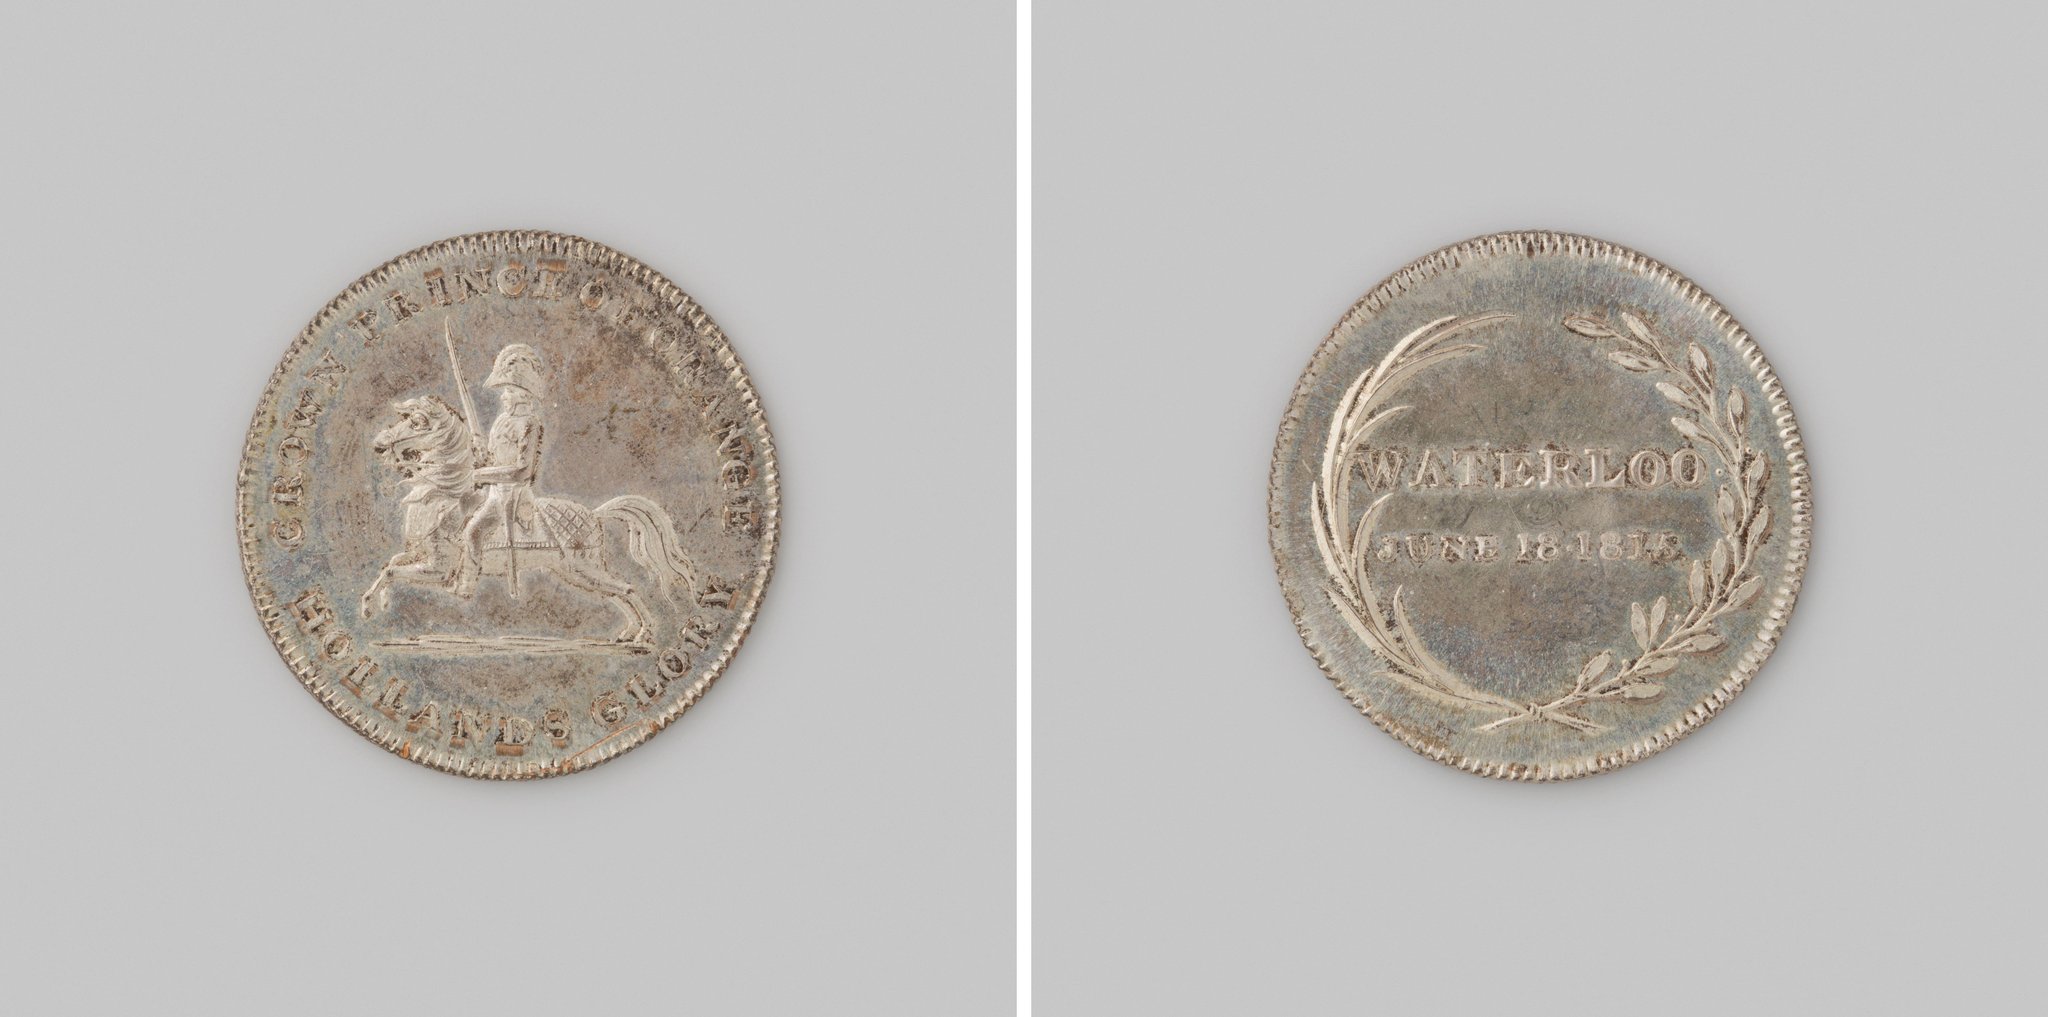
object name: history medal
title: De Kroonprins van Oranje in de Slag bij Waterloo 1815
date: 1815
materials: brass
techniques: striking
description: Verzilverde penning, op de voorzijde de kroonprins met blanke sabel te paard naar links, met omschrift, op de keerzijde twee regels tekst tussen palm- en lauwertak, Engelstalig.